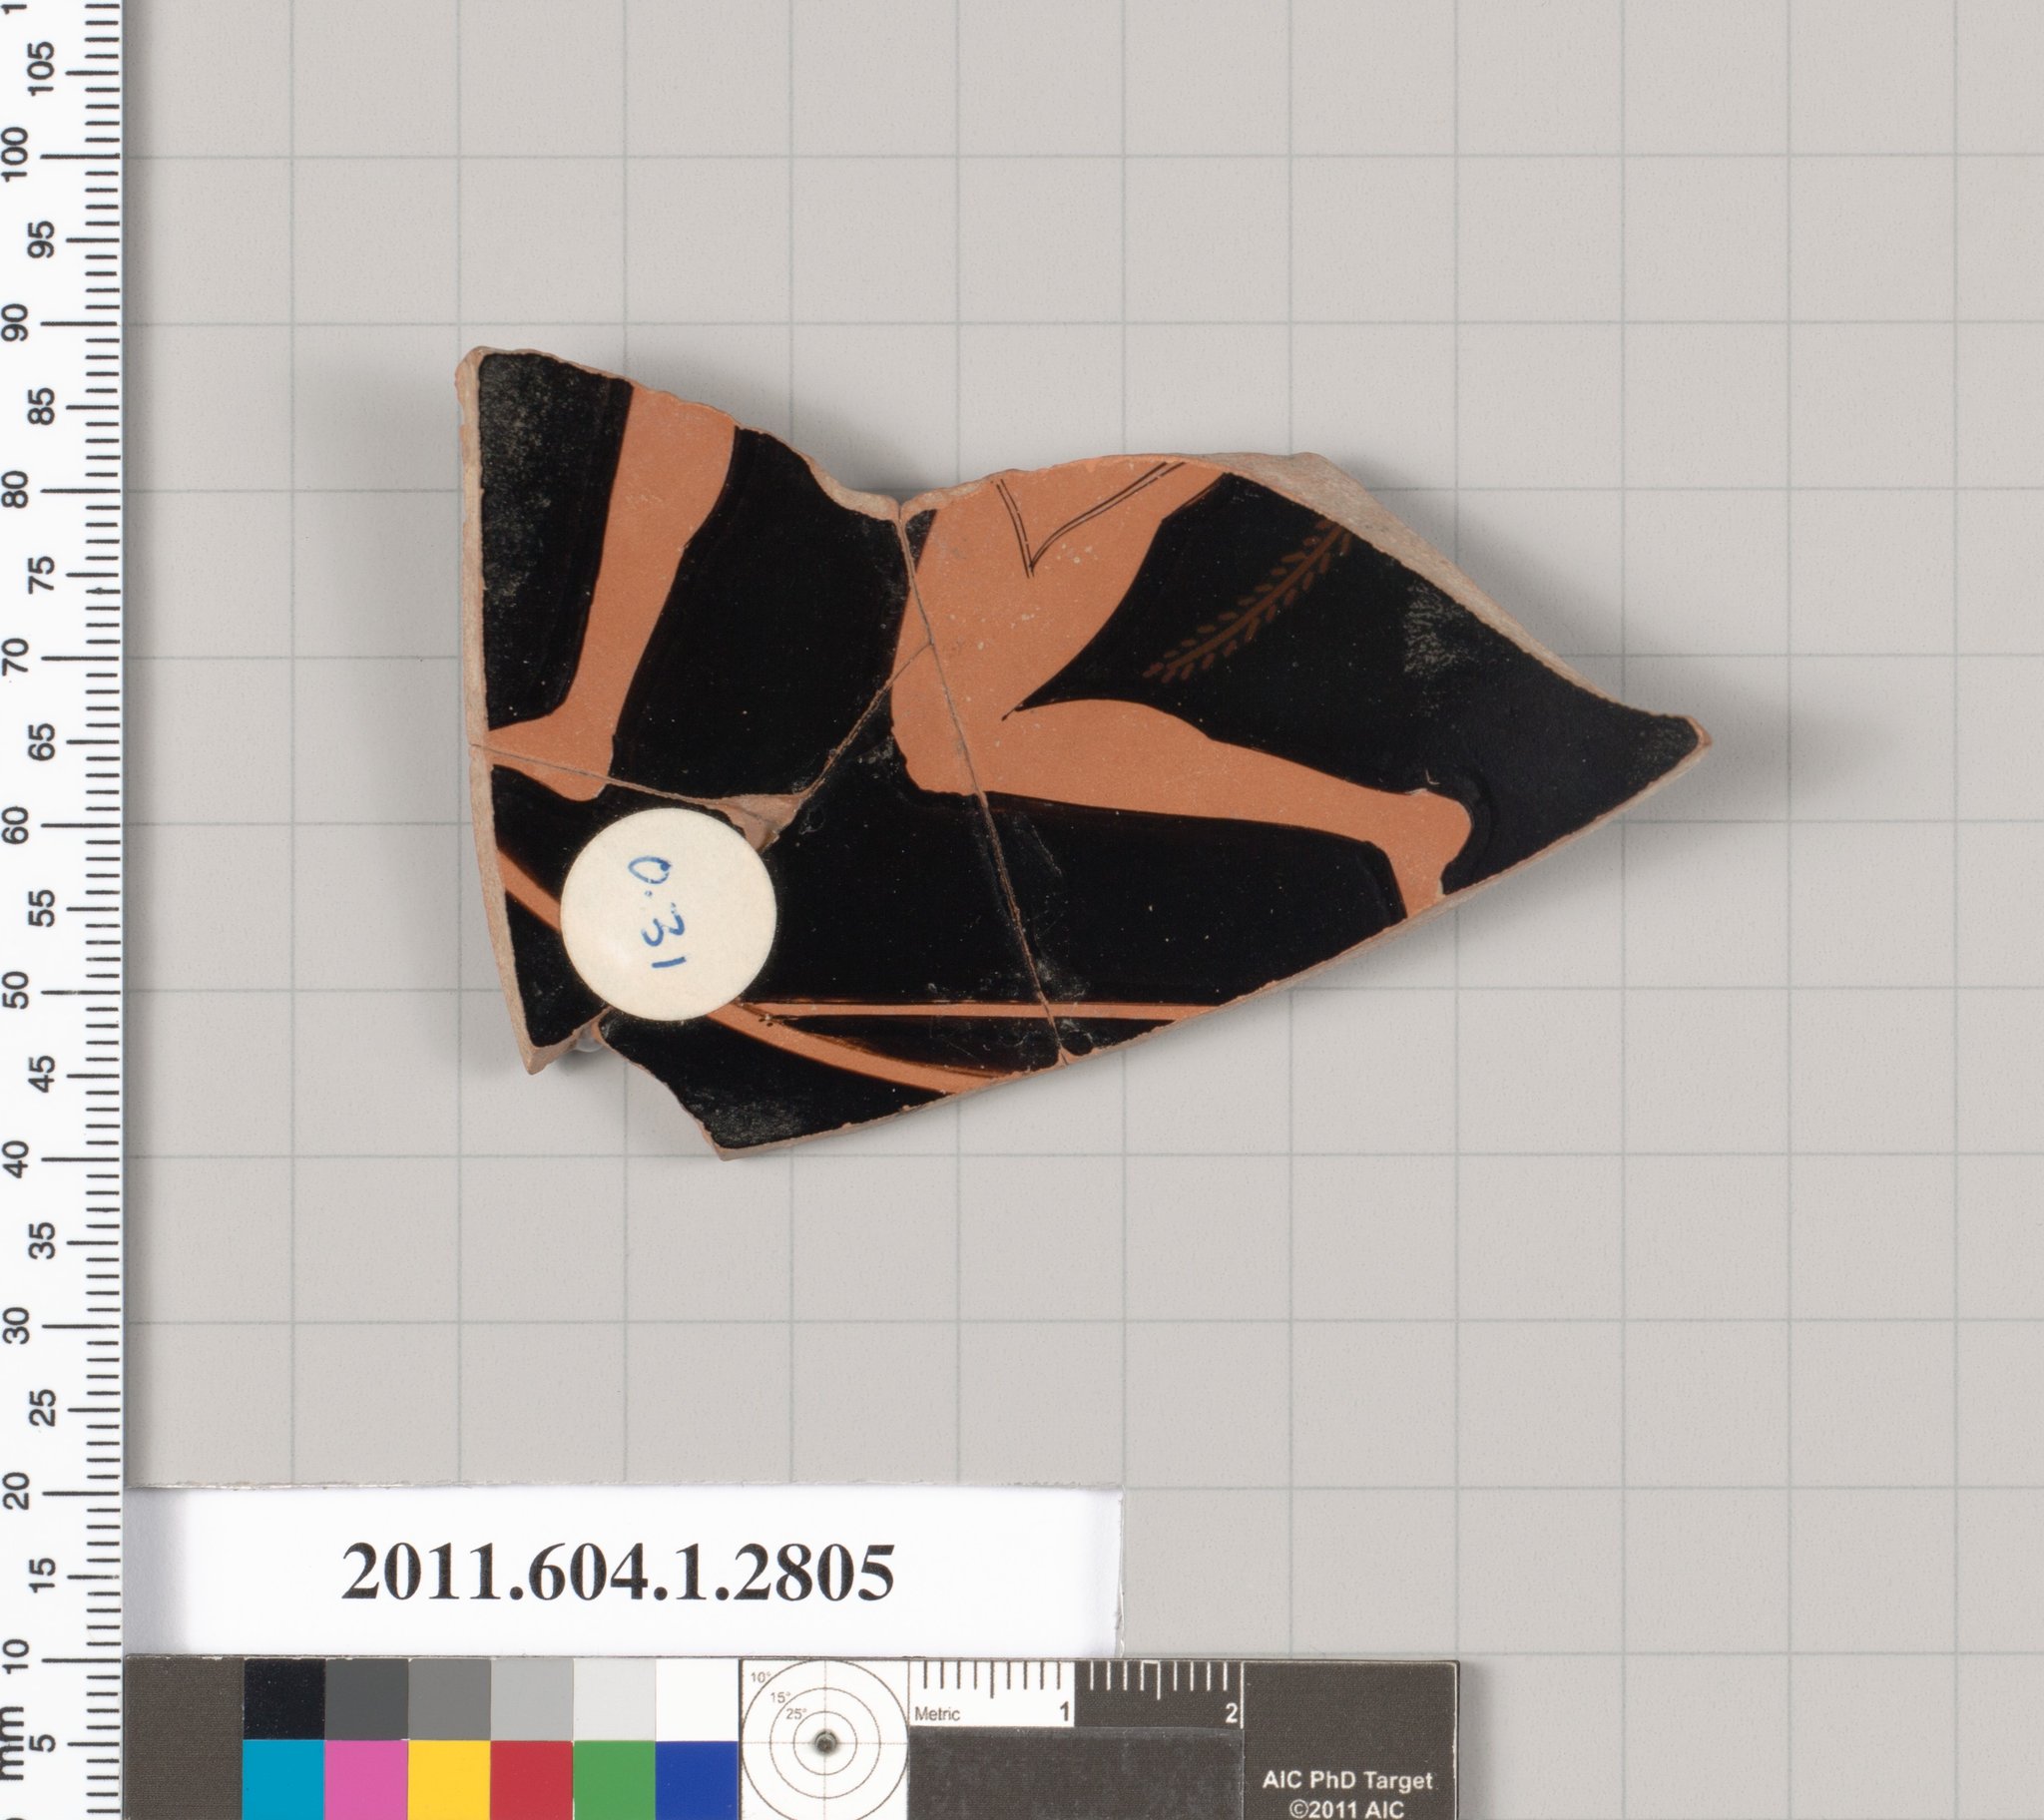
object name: kylix fragment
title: Terracotta fragment of a kylix (drinking cup)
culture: greek, attic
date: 520-500 BCE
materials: terracotta